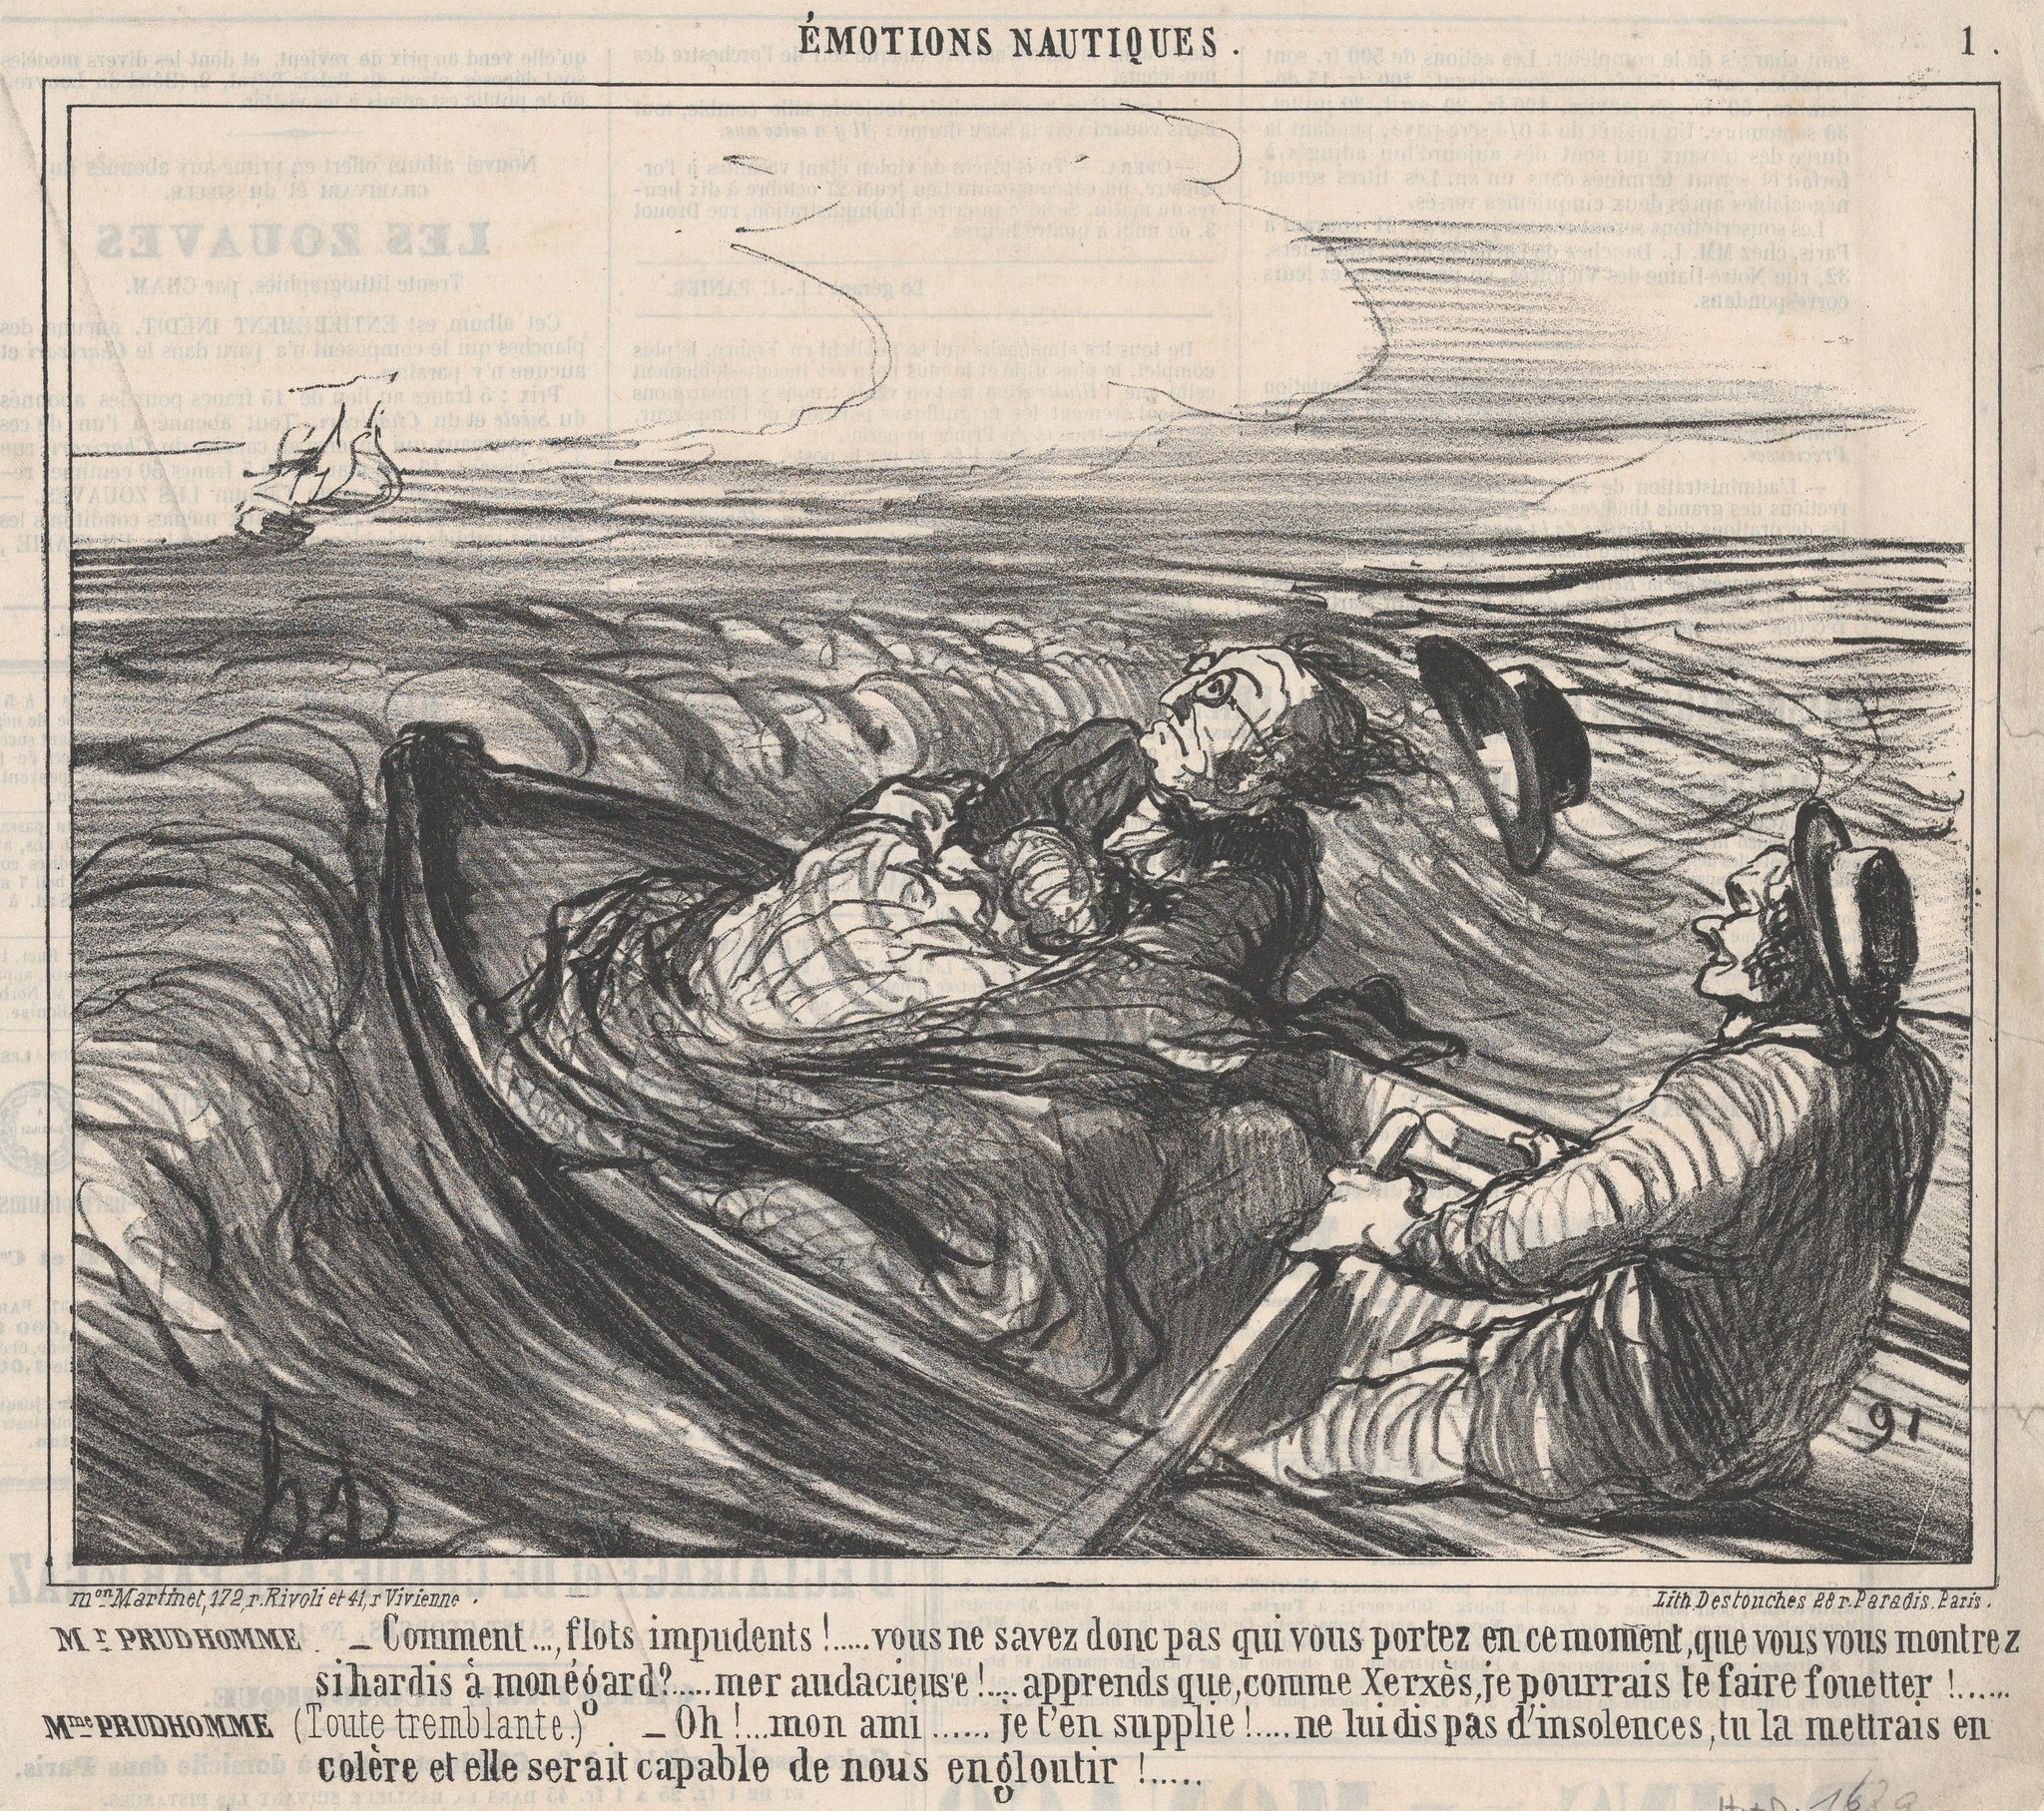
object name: print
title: Comment..., flots impudents!... vous ne savez donc pas qui vous portez en ce moment,...., from Émotions Nautiques, published in Le Charivari, October 26, 1859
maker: honoré daumier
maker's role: artist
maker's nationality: french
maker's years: 1808-1879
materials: paper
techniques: lithograph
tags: men,waves,boats